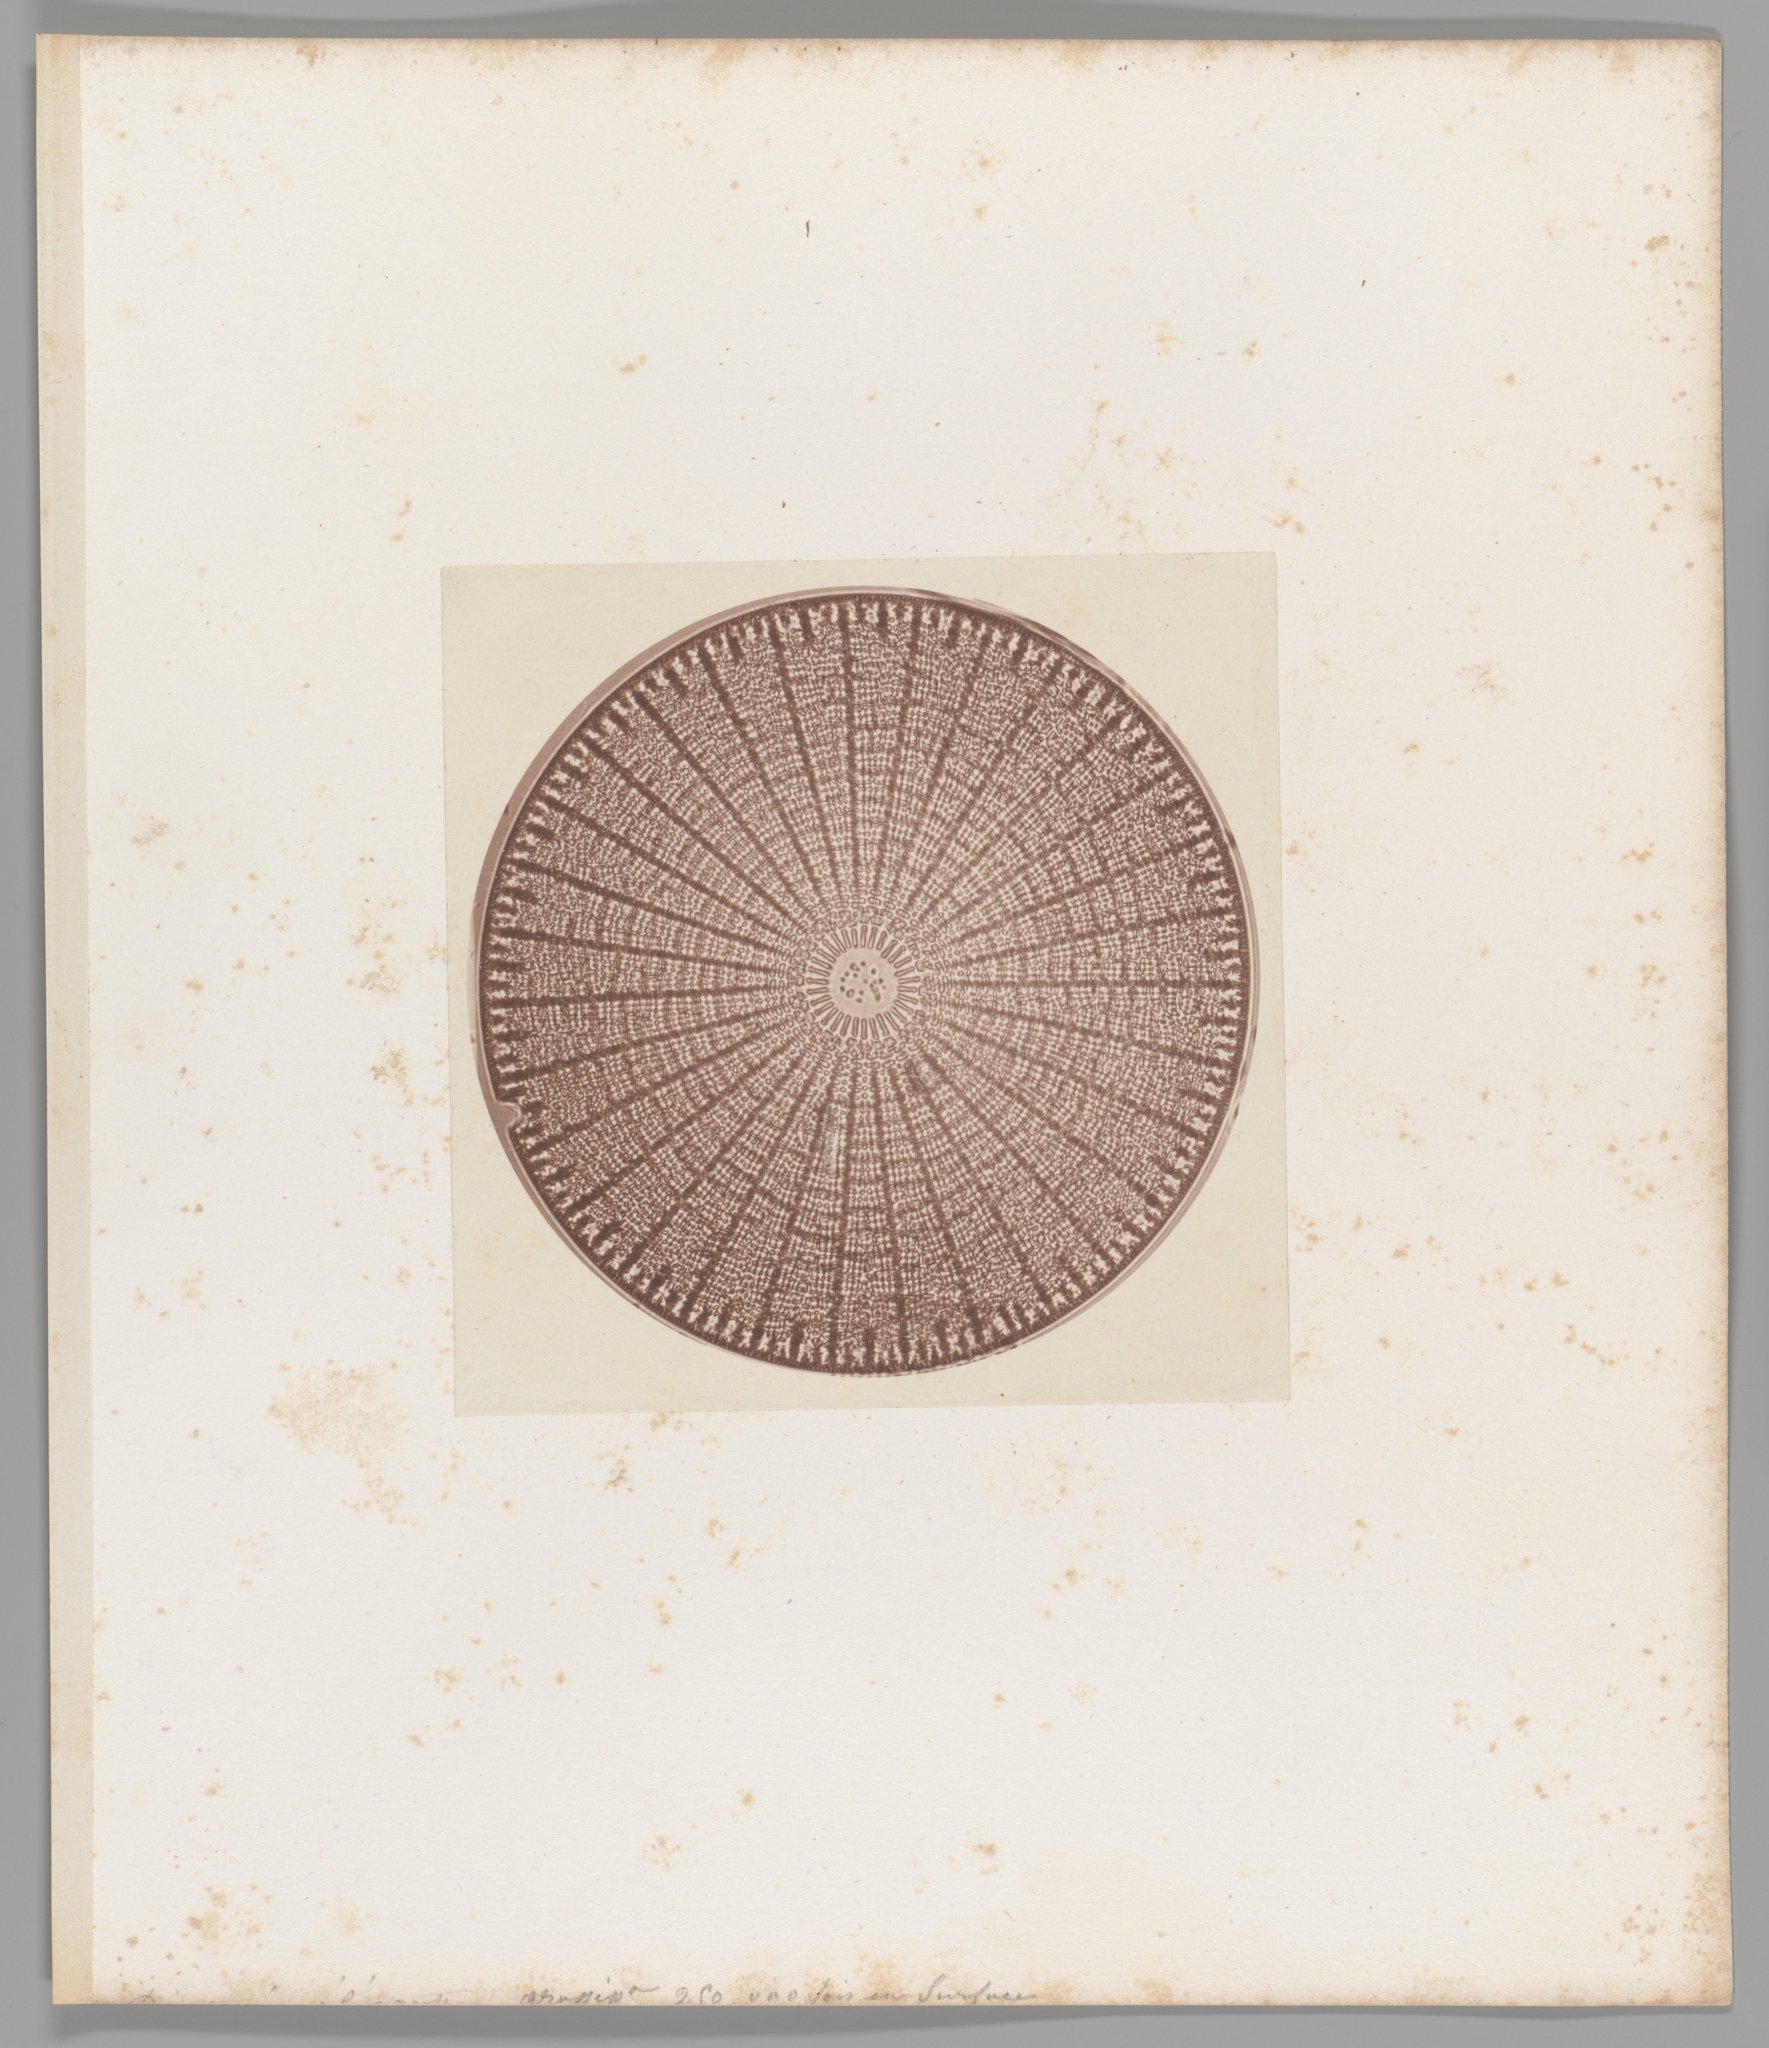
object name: photograph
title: Diatomée [Diatom]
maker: auguste-adolphe bertsch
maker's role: artist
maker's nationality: french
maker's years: 1813-1871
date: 1853-1857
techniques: salted paper print